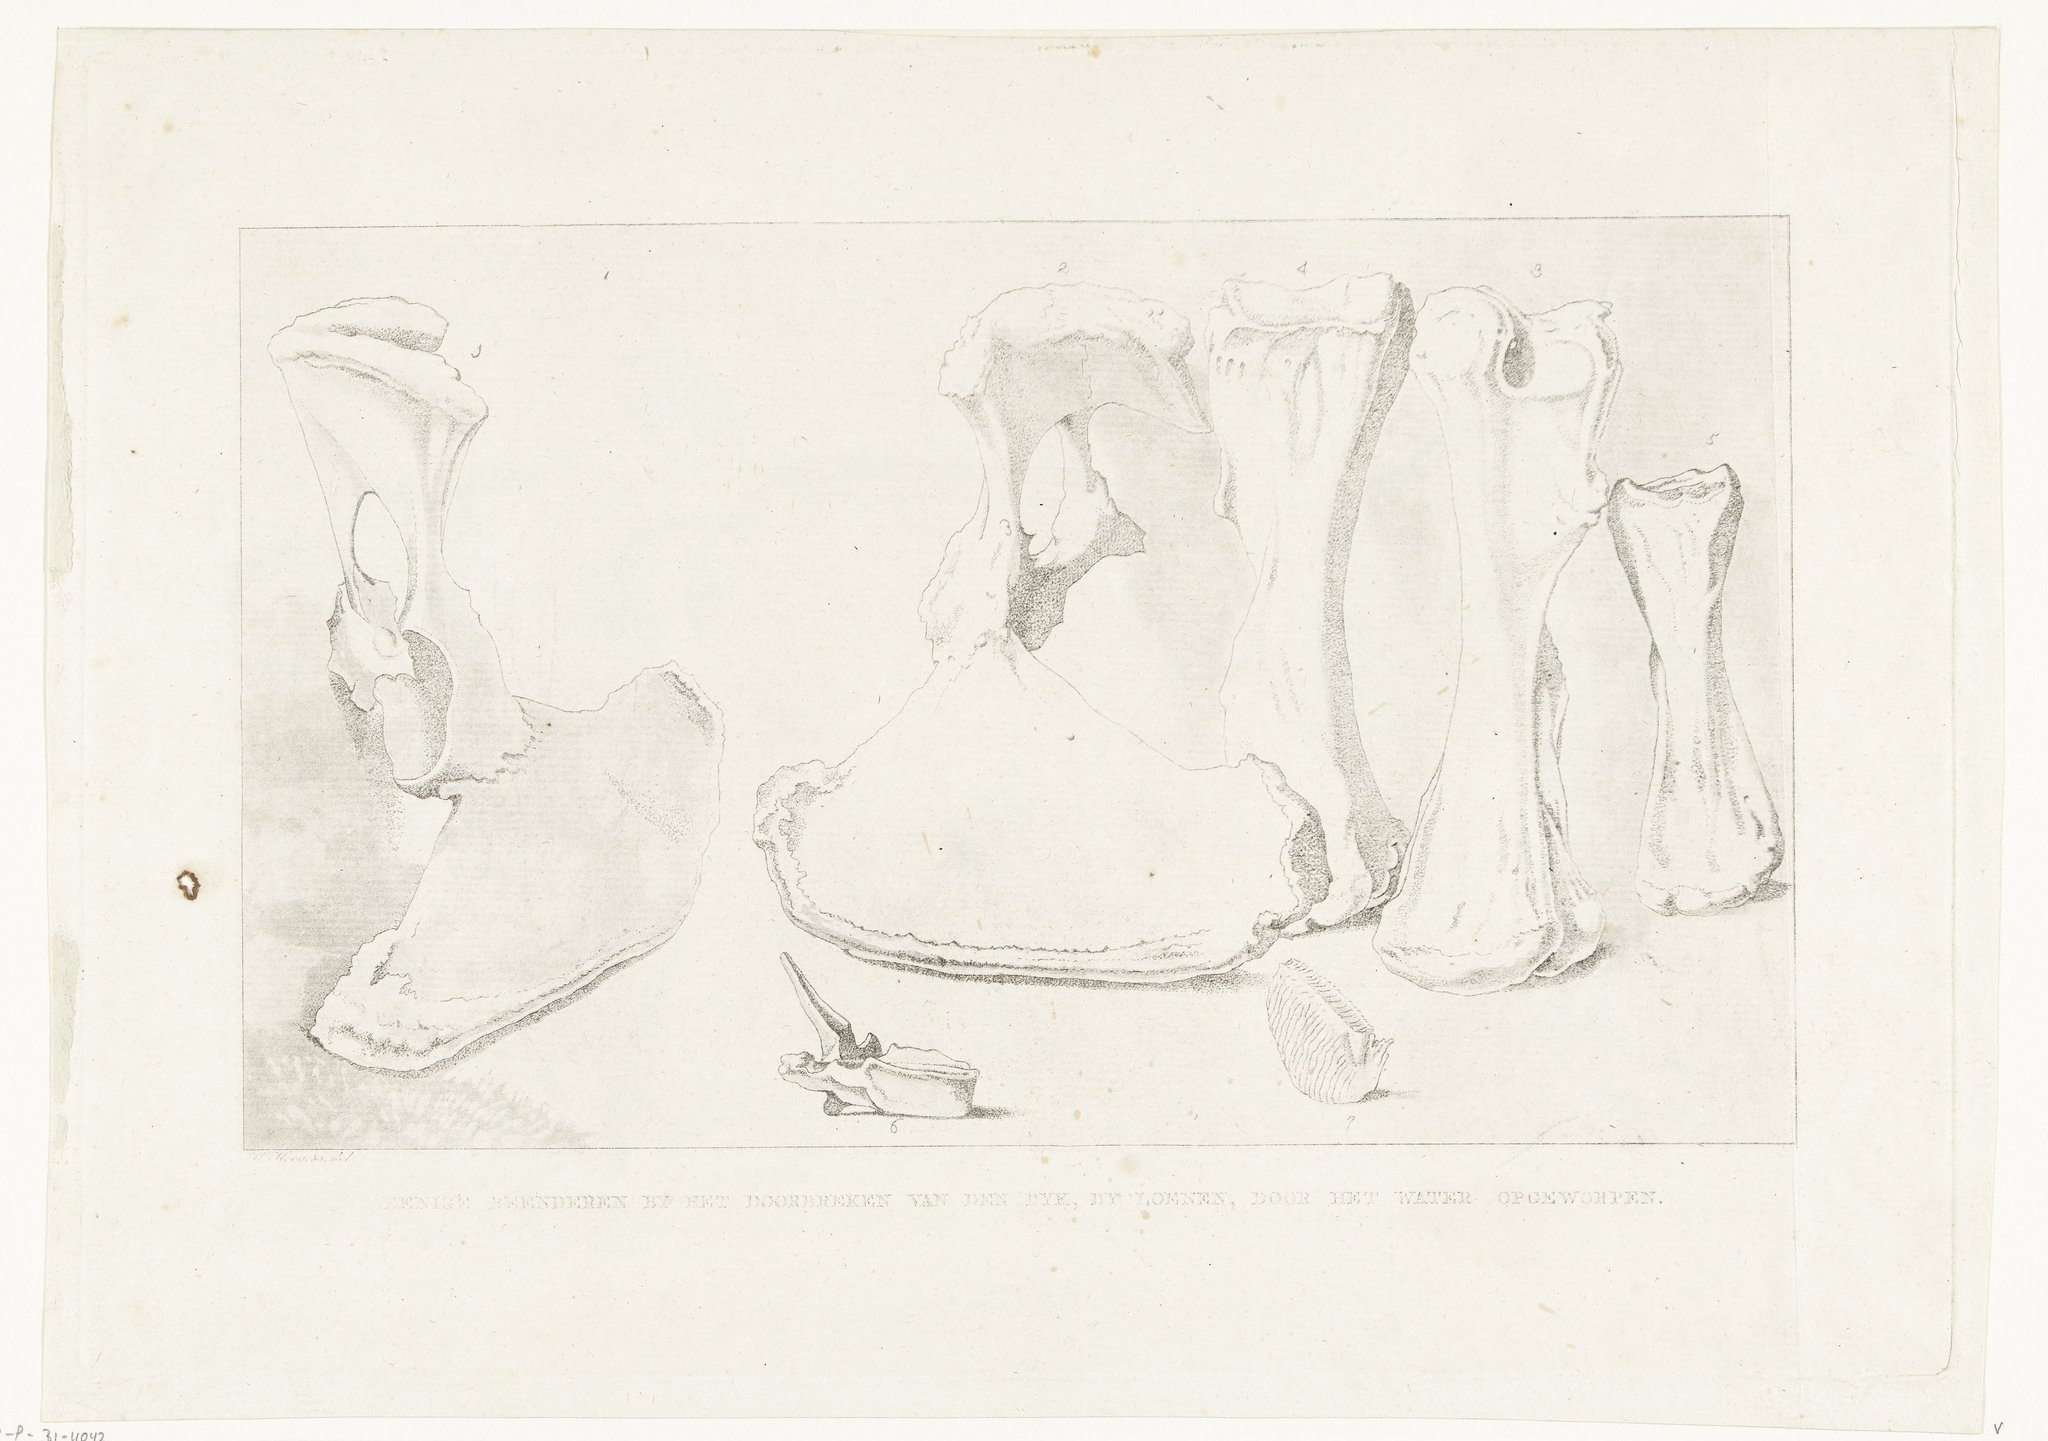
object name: book illustration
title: Aangespoelde beenderen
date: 1809-1810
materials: paper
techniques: aquatint, etching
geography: netherlands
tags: bones in general (human body), gelderland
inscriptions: collector's mark: Lugt 2228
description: Plaat gemaakt voor: H. Ewijk, Platen en kaarten behorende tot het geschiedkundig verslag der dijkbreuken en overstroomingen, langs de rivieren in het Koningrijk Holland, voorgevallen in louwmaand MDCCCIX. Amsterdam, J. Allart en J. Ruys, 1809.